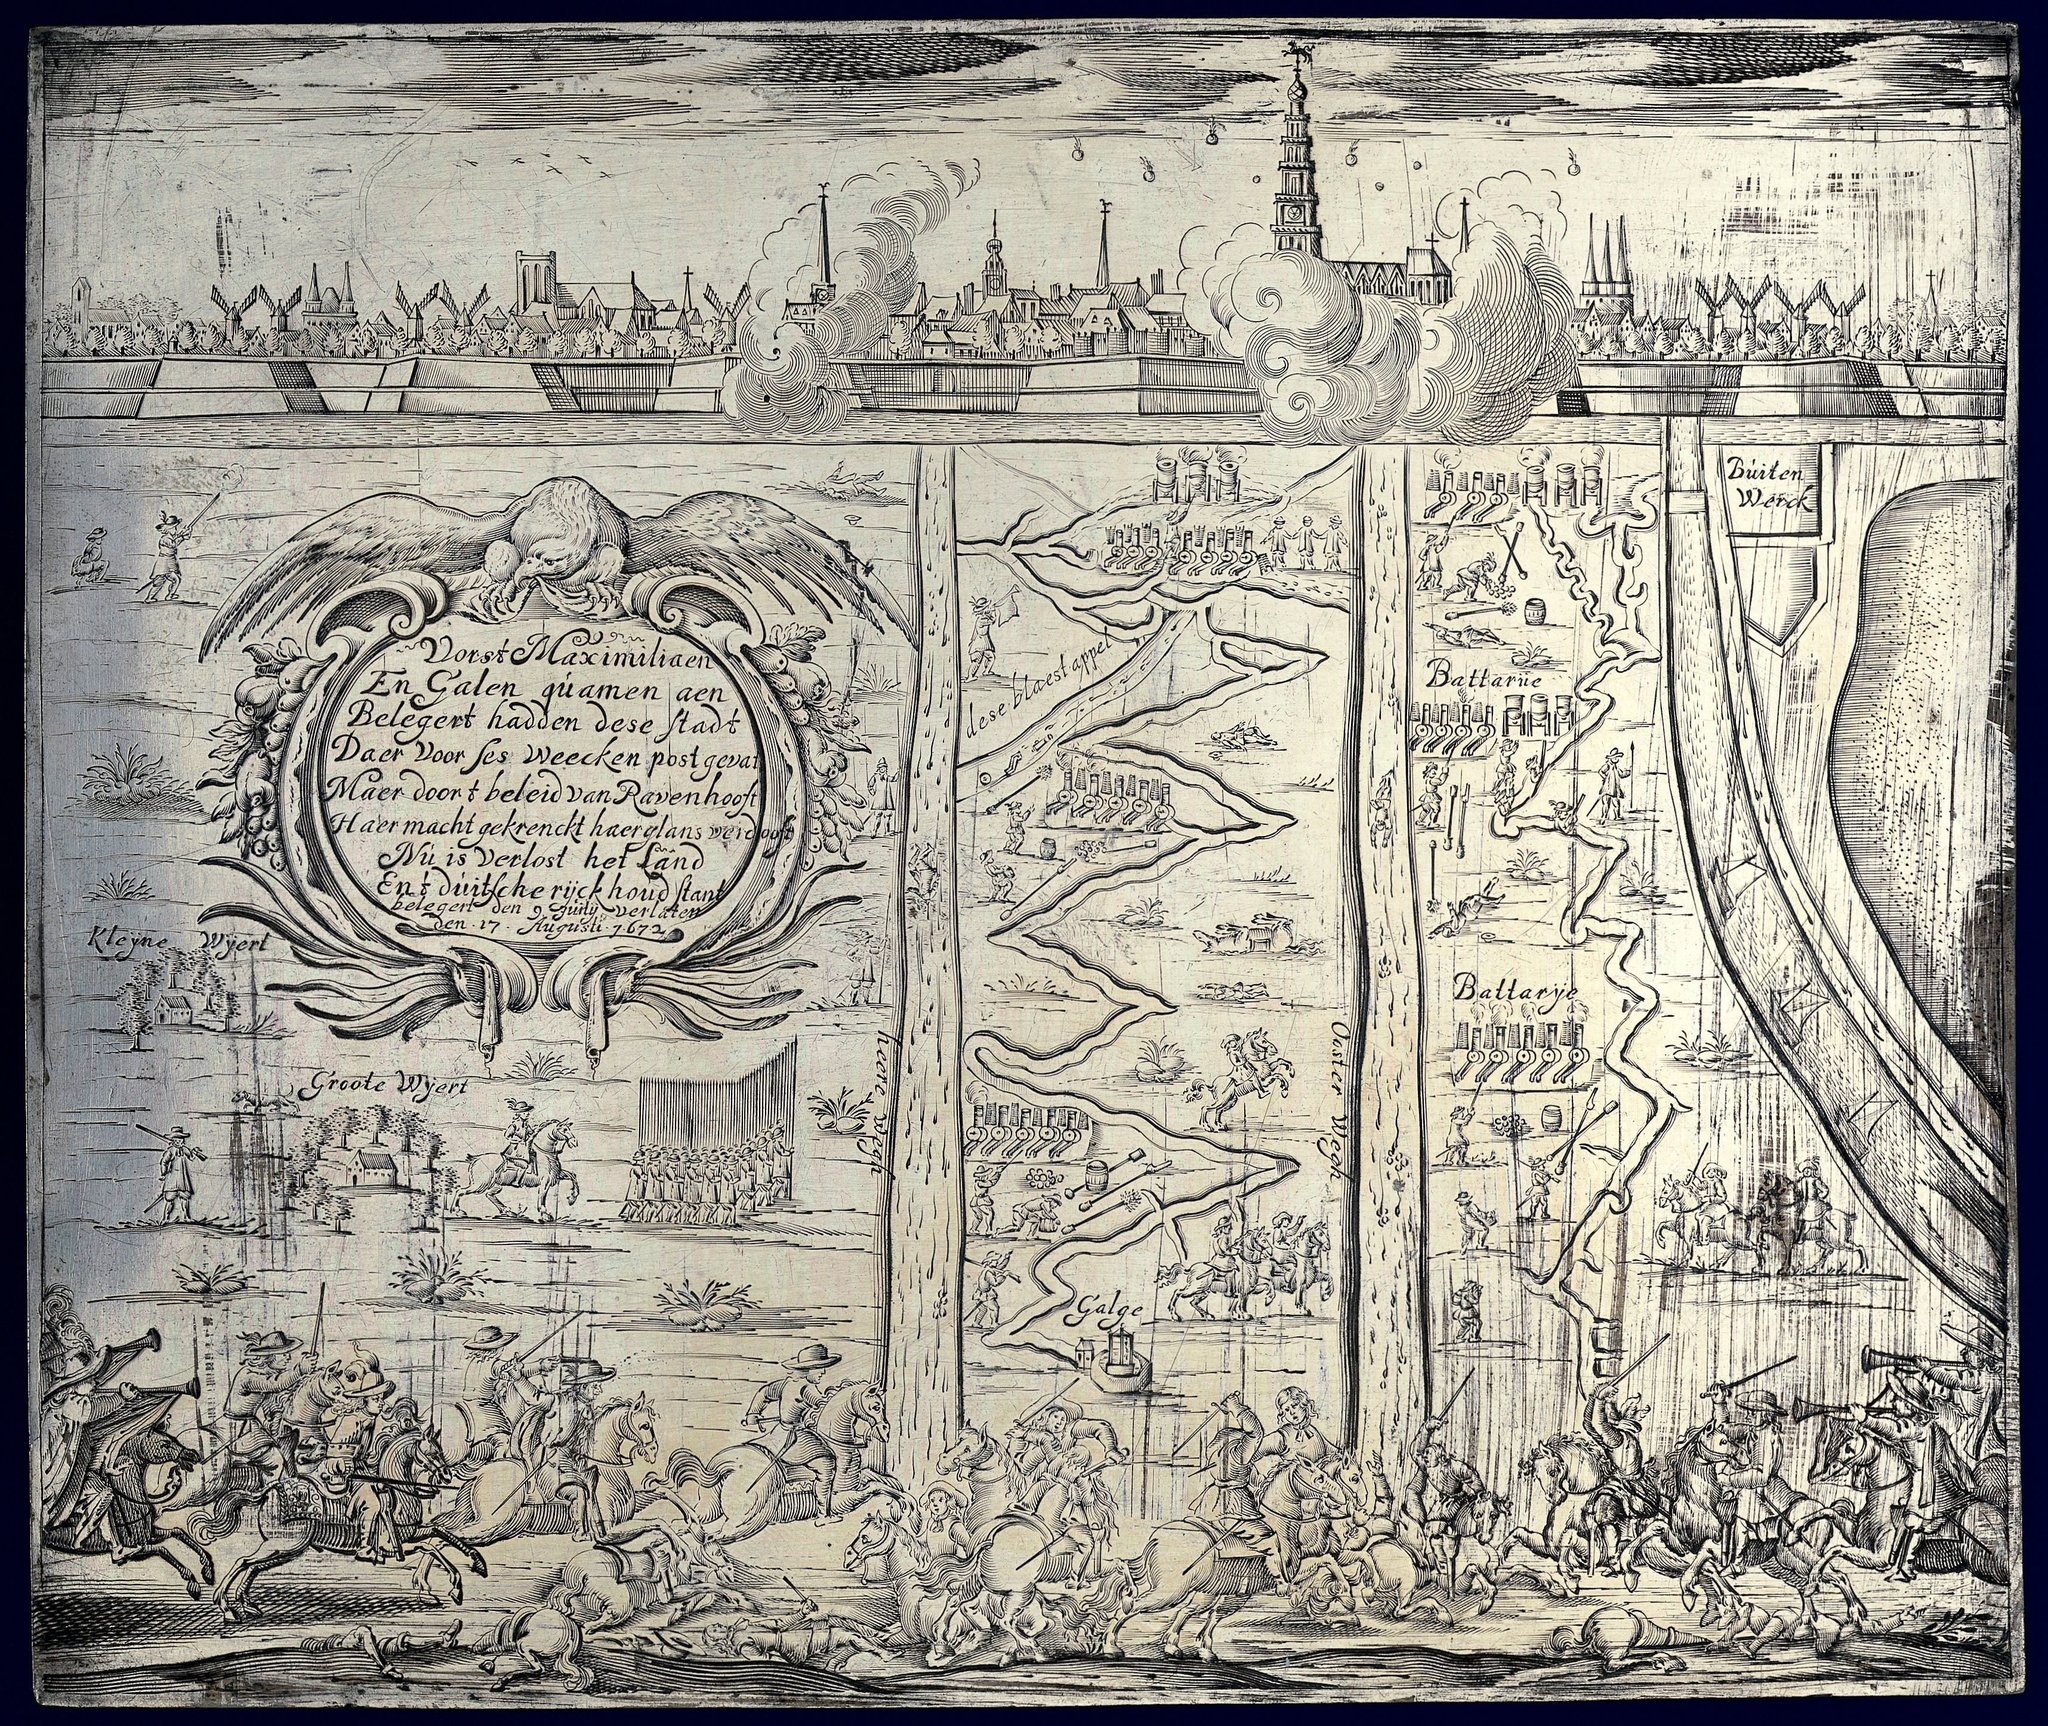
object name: plate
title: Belegering van Groningen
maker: Anonymous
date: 1674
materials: silver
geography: amsterdam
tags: siege, rampjaar (disaster year)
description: Plaque depicting the Siege of Groningen by M. van Keulen, silver, 17th century. This plaque depicts the siege and relief of Groningen. The bishops of Cologne and Münster laid siege to the city from 9 July to 17 August 1672. Led by Karel von Rabenhaupt the city managed to overcome its attackers. After the bombardment of Groningen Bernhard van Galen, the bishop van Münster, became known as Bomber Berend.